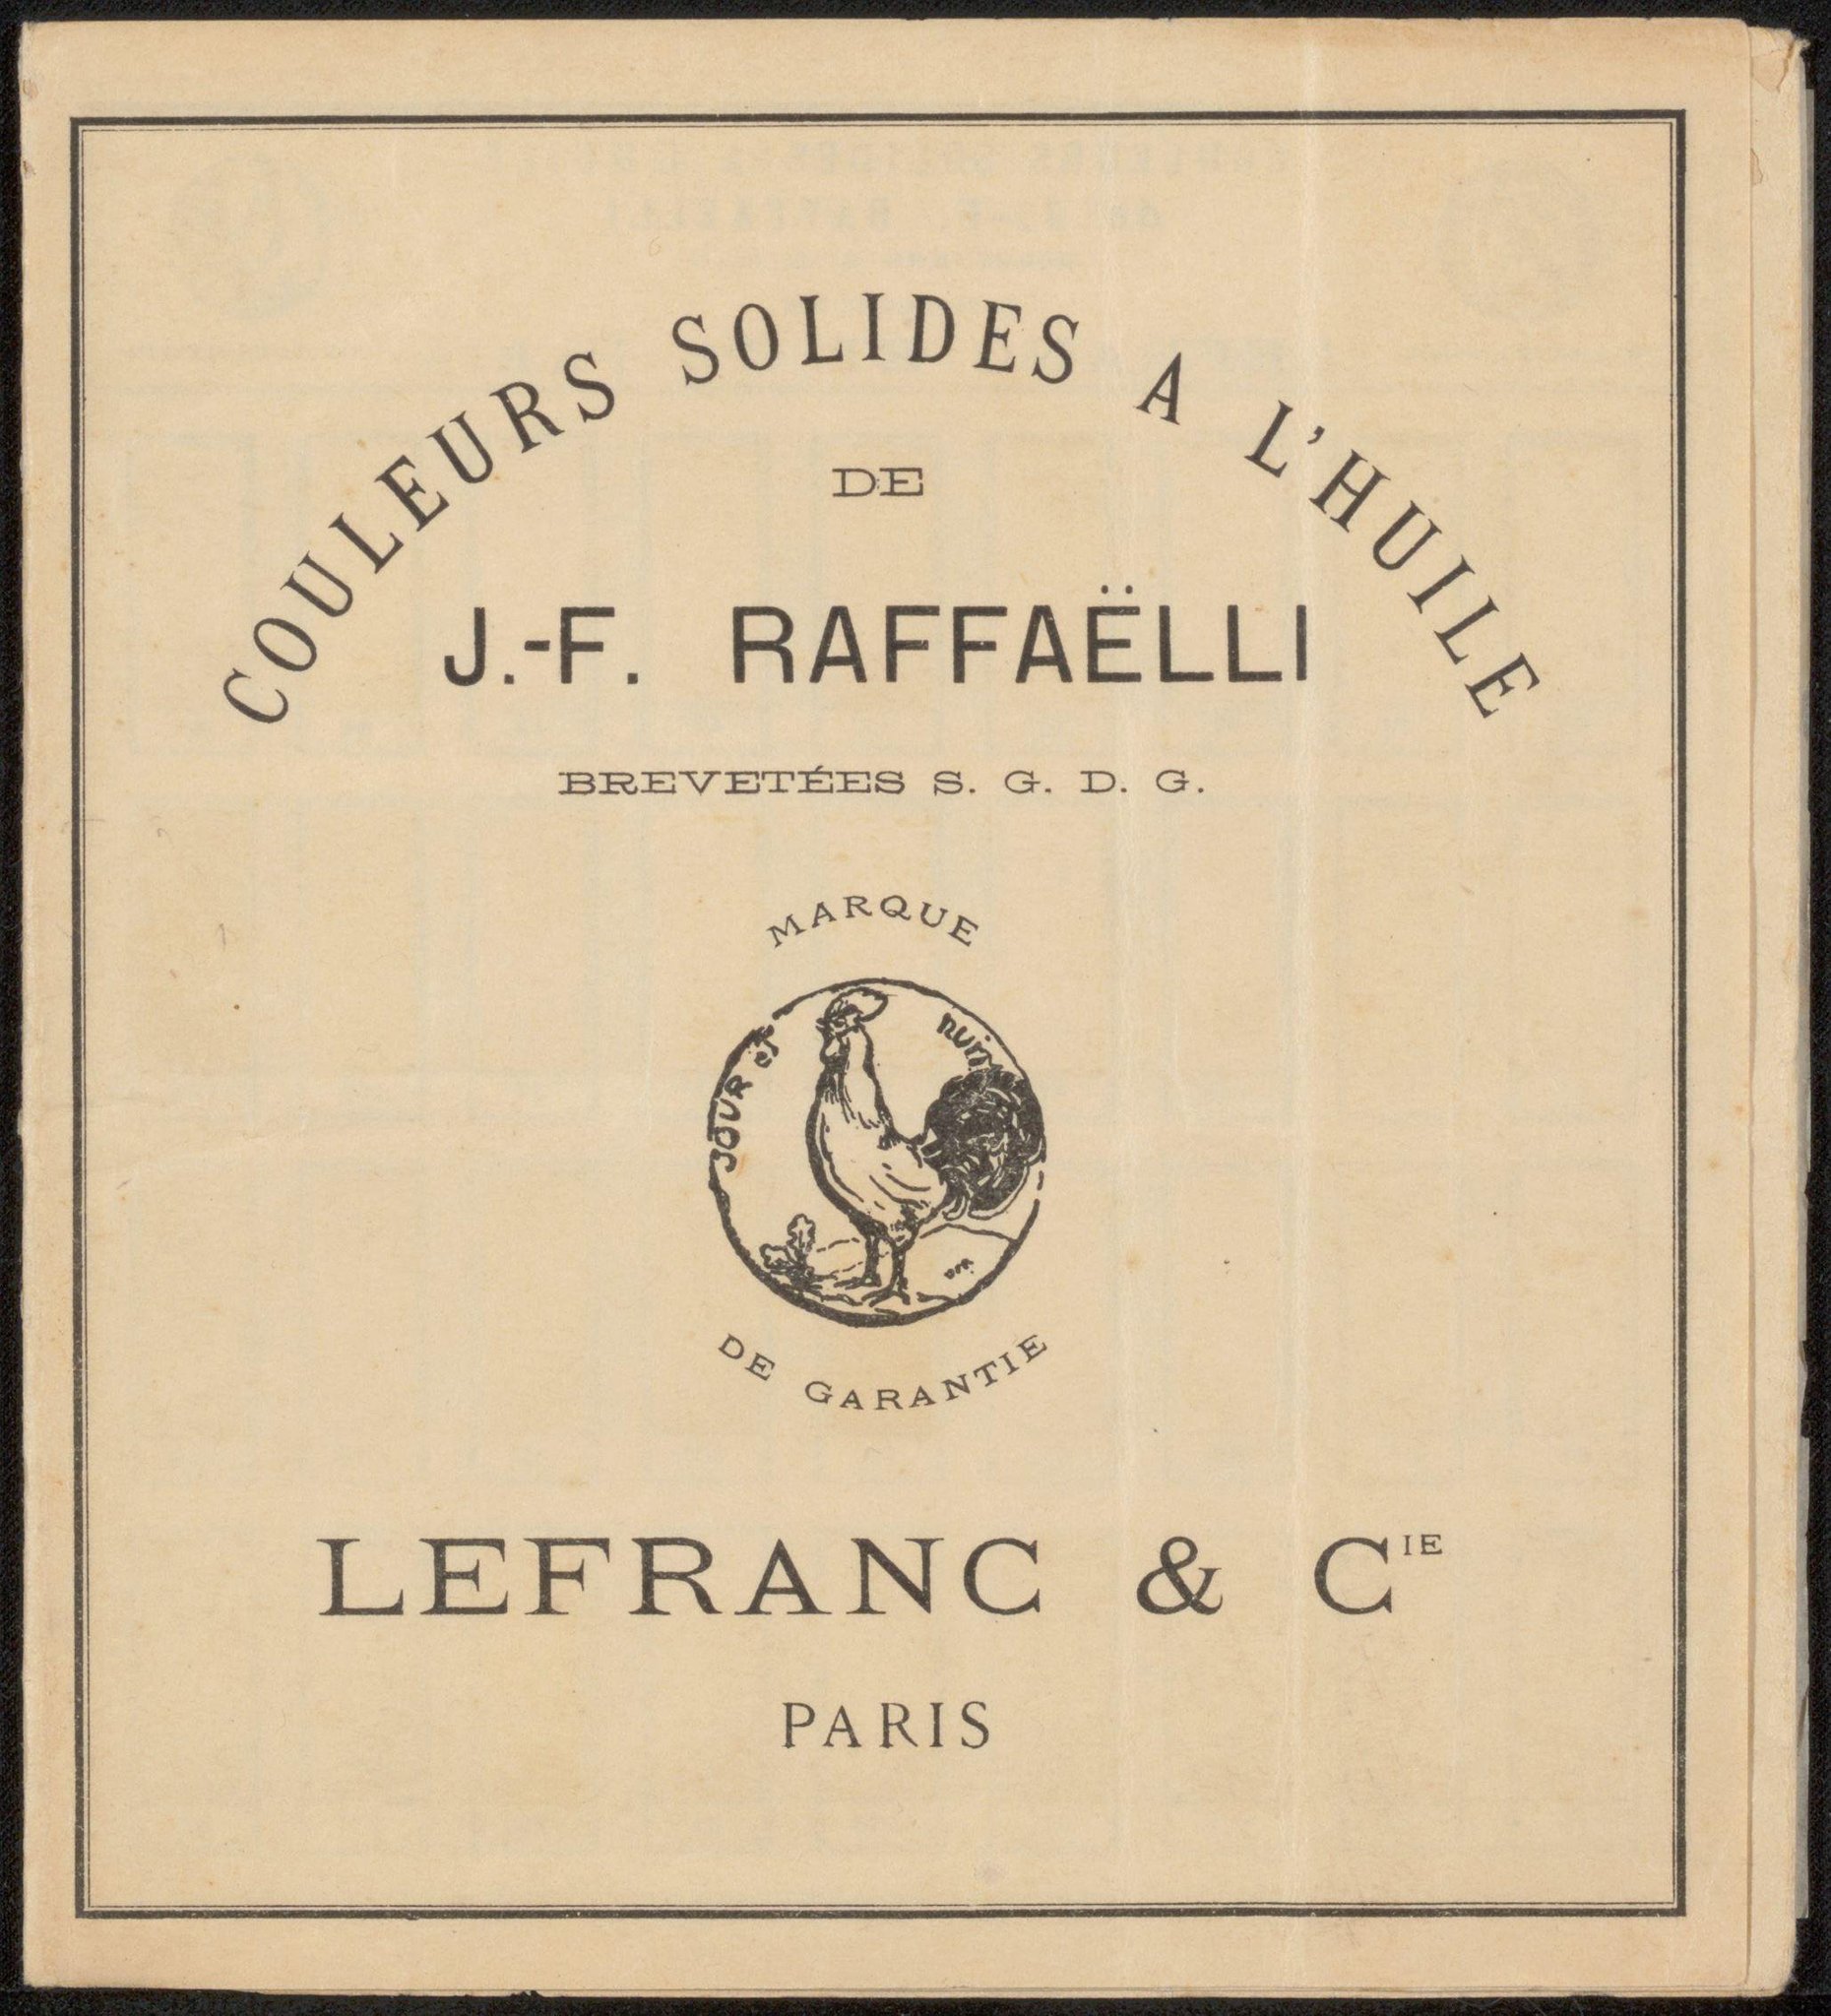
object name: brochure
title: Brochure uit archief Philip Zilcken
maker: Anonymous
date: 1867-1930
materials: paint, paper, pencil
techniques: printing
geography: paris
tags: paris, print maker, jean françois raffaëlli, the hague, painter, draughtsman, philip zilcken, landscapes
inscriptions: collector's mark: ‘RPK’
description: RP-D-1982-43-RAFFAËLLI(J.F.)-DOC.1 en RP-D-1982-43-RAFFAËLLI(J.F.)-DOC.2 geven een toelichting op deze brochure.